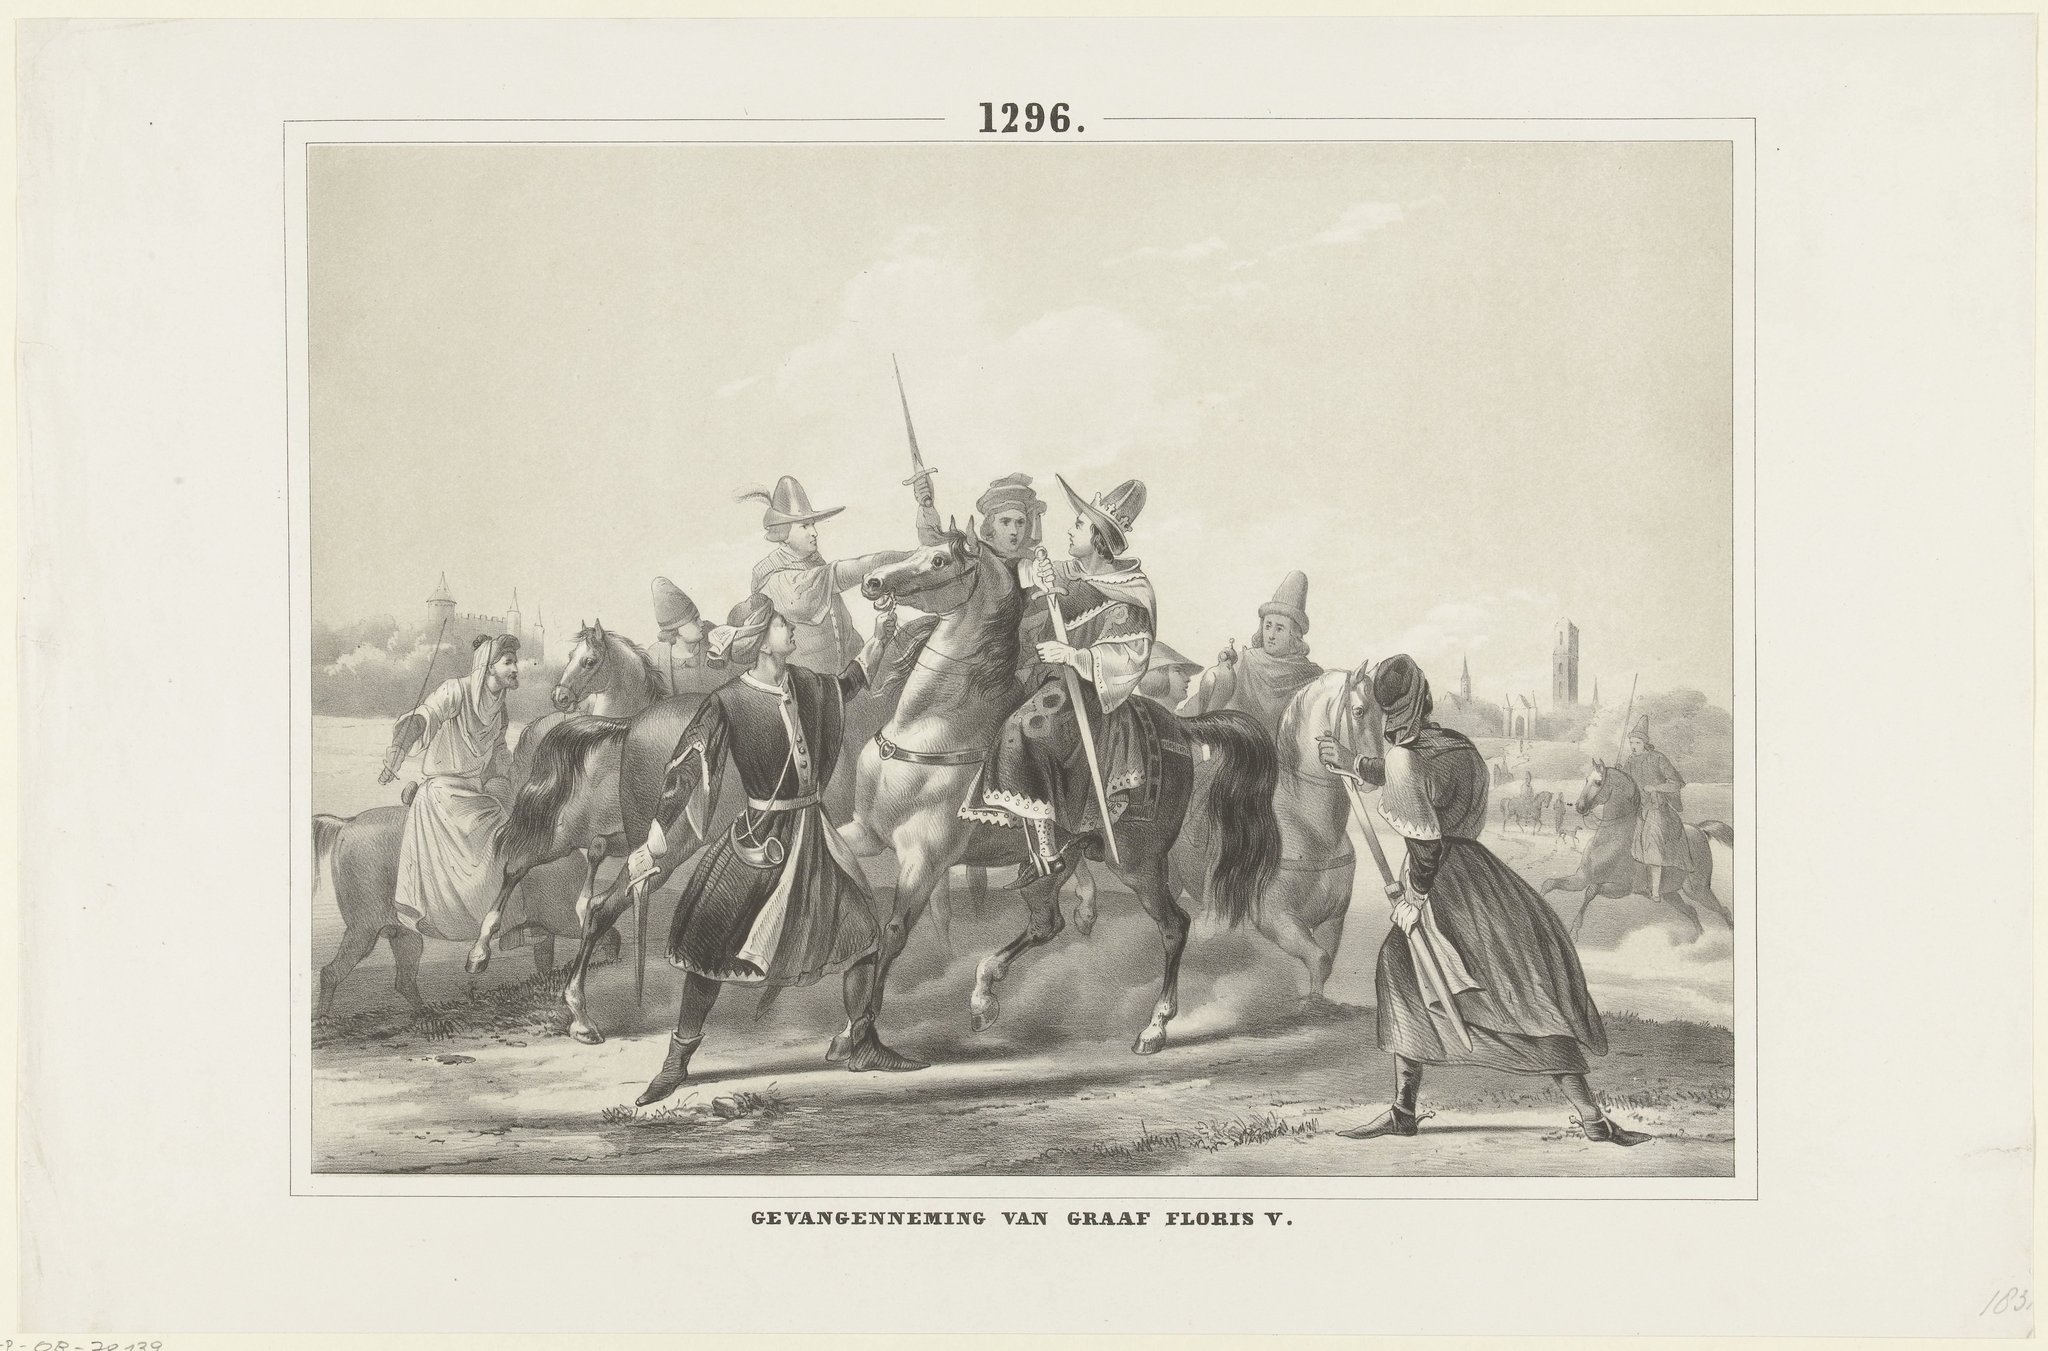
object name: history print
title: 1296 / Gevangenneming van graaf Floris V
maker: Anonymous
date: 1853-1855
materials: paper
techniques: lithograph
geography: netherlands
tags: leiden, floris v (graaf van holland en zeeland), sports, games ~ animals (+ hunting with falcon, hawk; falconry), netherlands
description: Illustratie voor: J.H. Eichman & H. Altmann, Vaderlandsche historieplaten voor scholen en huisgezinnen, Leiden, 1855. Dit nummer is een door het RPK toegevoegd nummer en staat niet in Frederik Muller, het werk waar de prent voor is gemaakt of uit afkomstig is, staat wel vermeld in Frederik Muller.